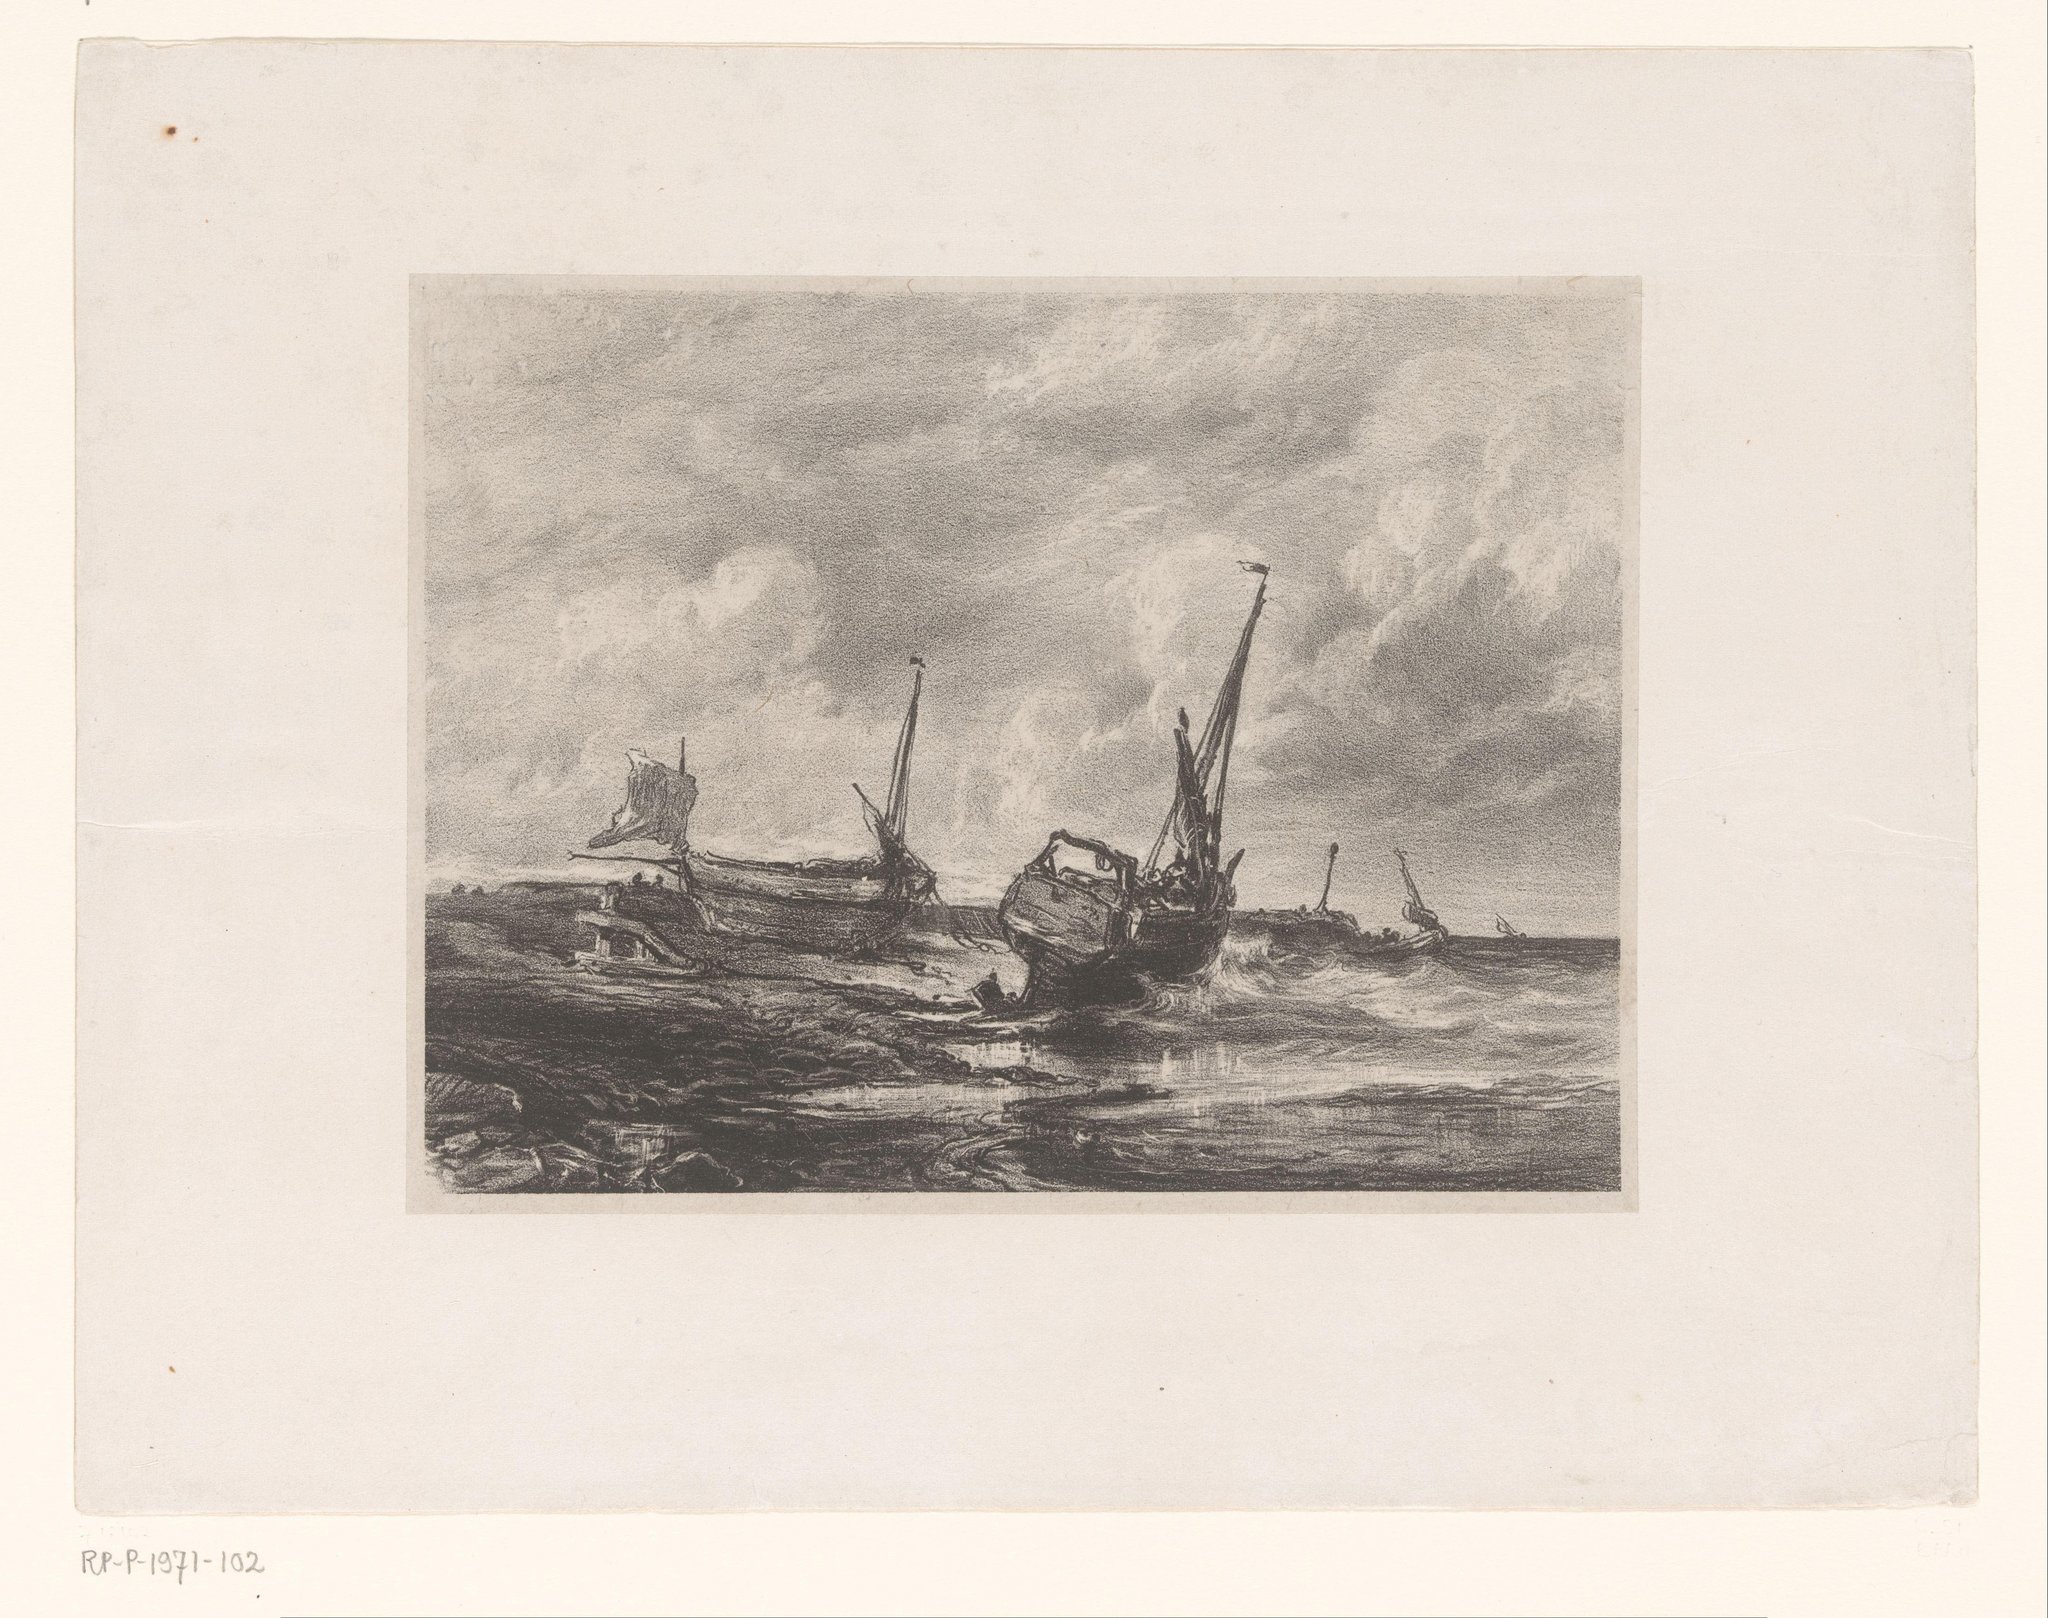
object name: print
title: Boten op het strand bij eb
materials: paper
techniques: lithograph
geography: paris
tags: ebb, low tide, ships (in general) - cc - more than one ship, beach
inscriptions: collector's mark: Lugt 2760, collector's mark: Lugt 2228a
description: Kopie in spiegelbeeld van RP-P-1971-101 (zie Hédiard 1906, p. 31).